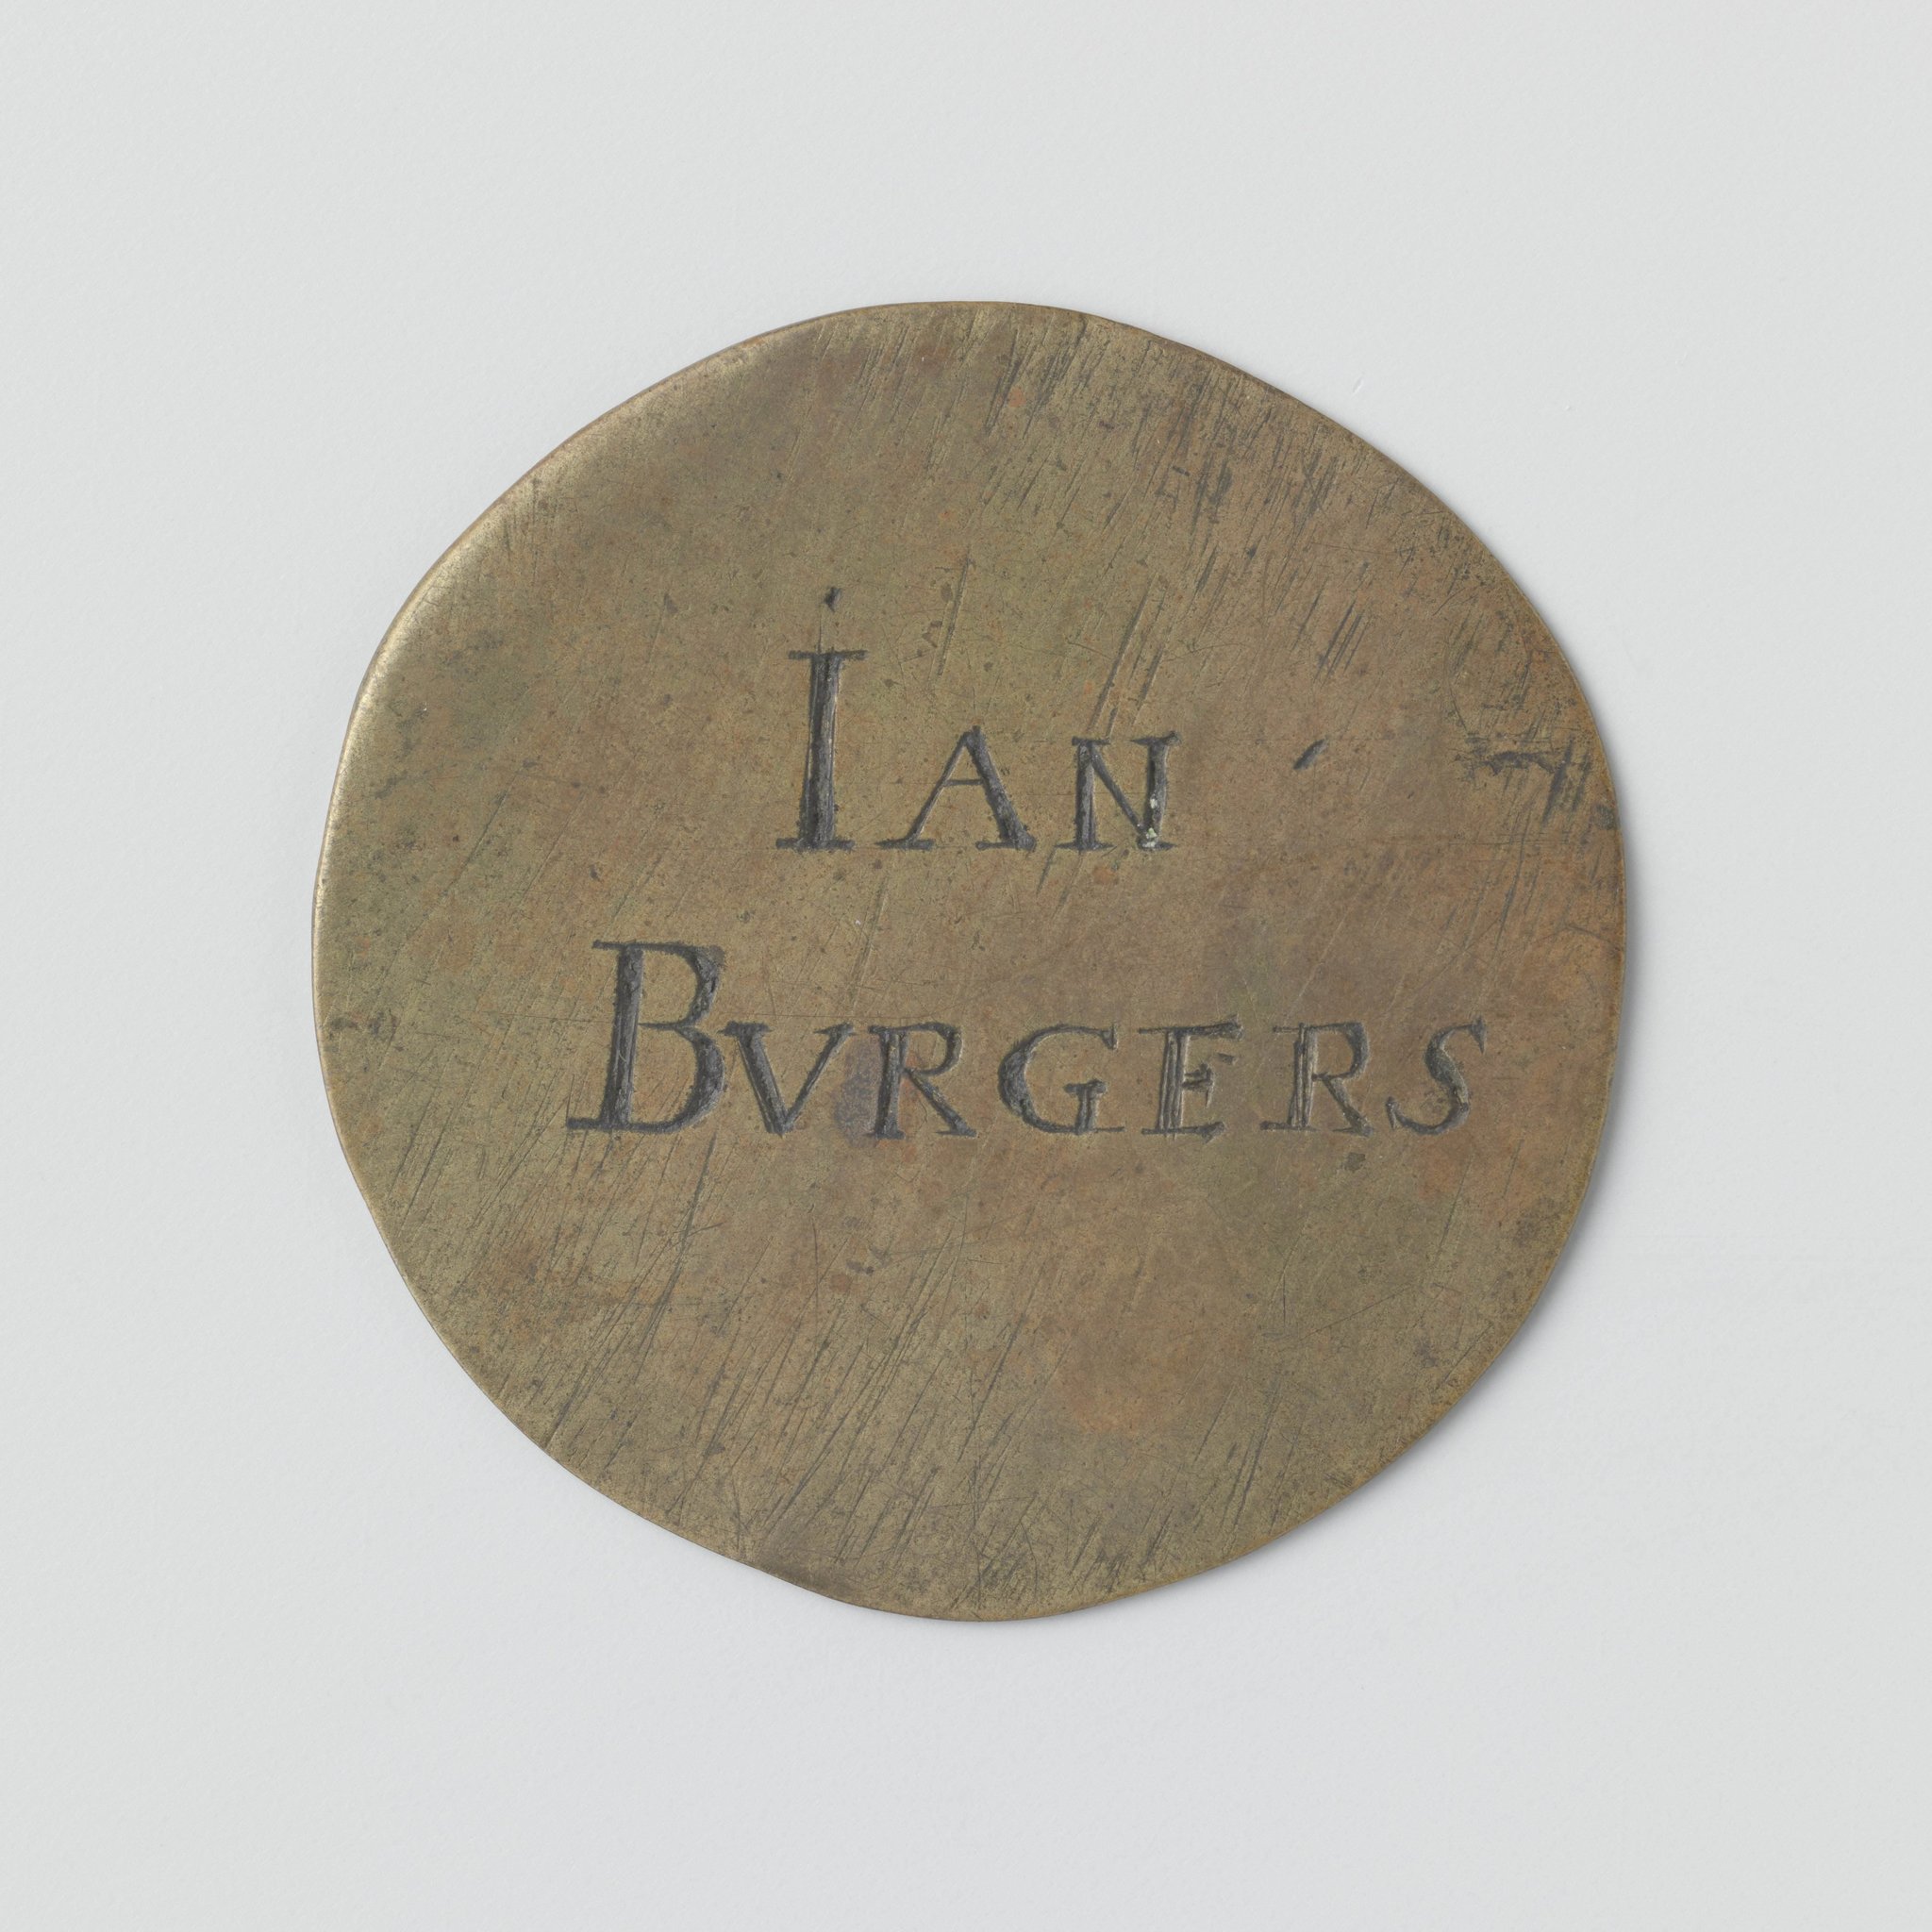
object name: medal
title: Mandemakersgilde van Amsterdam, gildepenning van Jan Burgers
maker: Anonymous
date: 1642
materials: brass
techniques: engraving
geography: amsterdam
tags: amsterdam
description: Messing penning. Voorzijde: opschrift. Keerzijde: twee letters M boven letter G